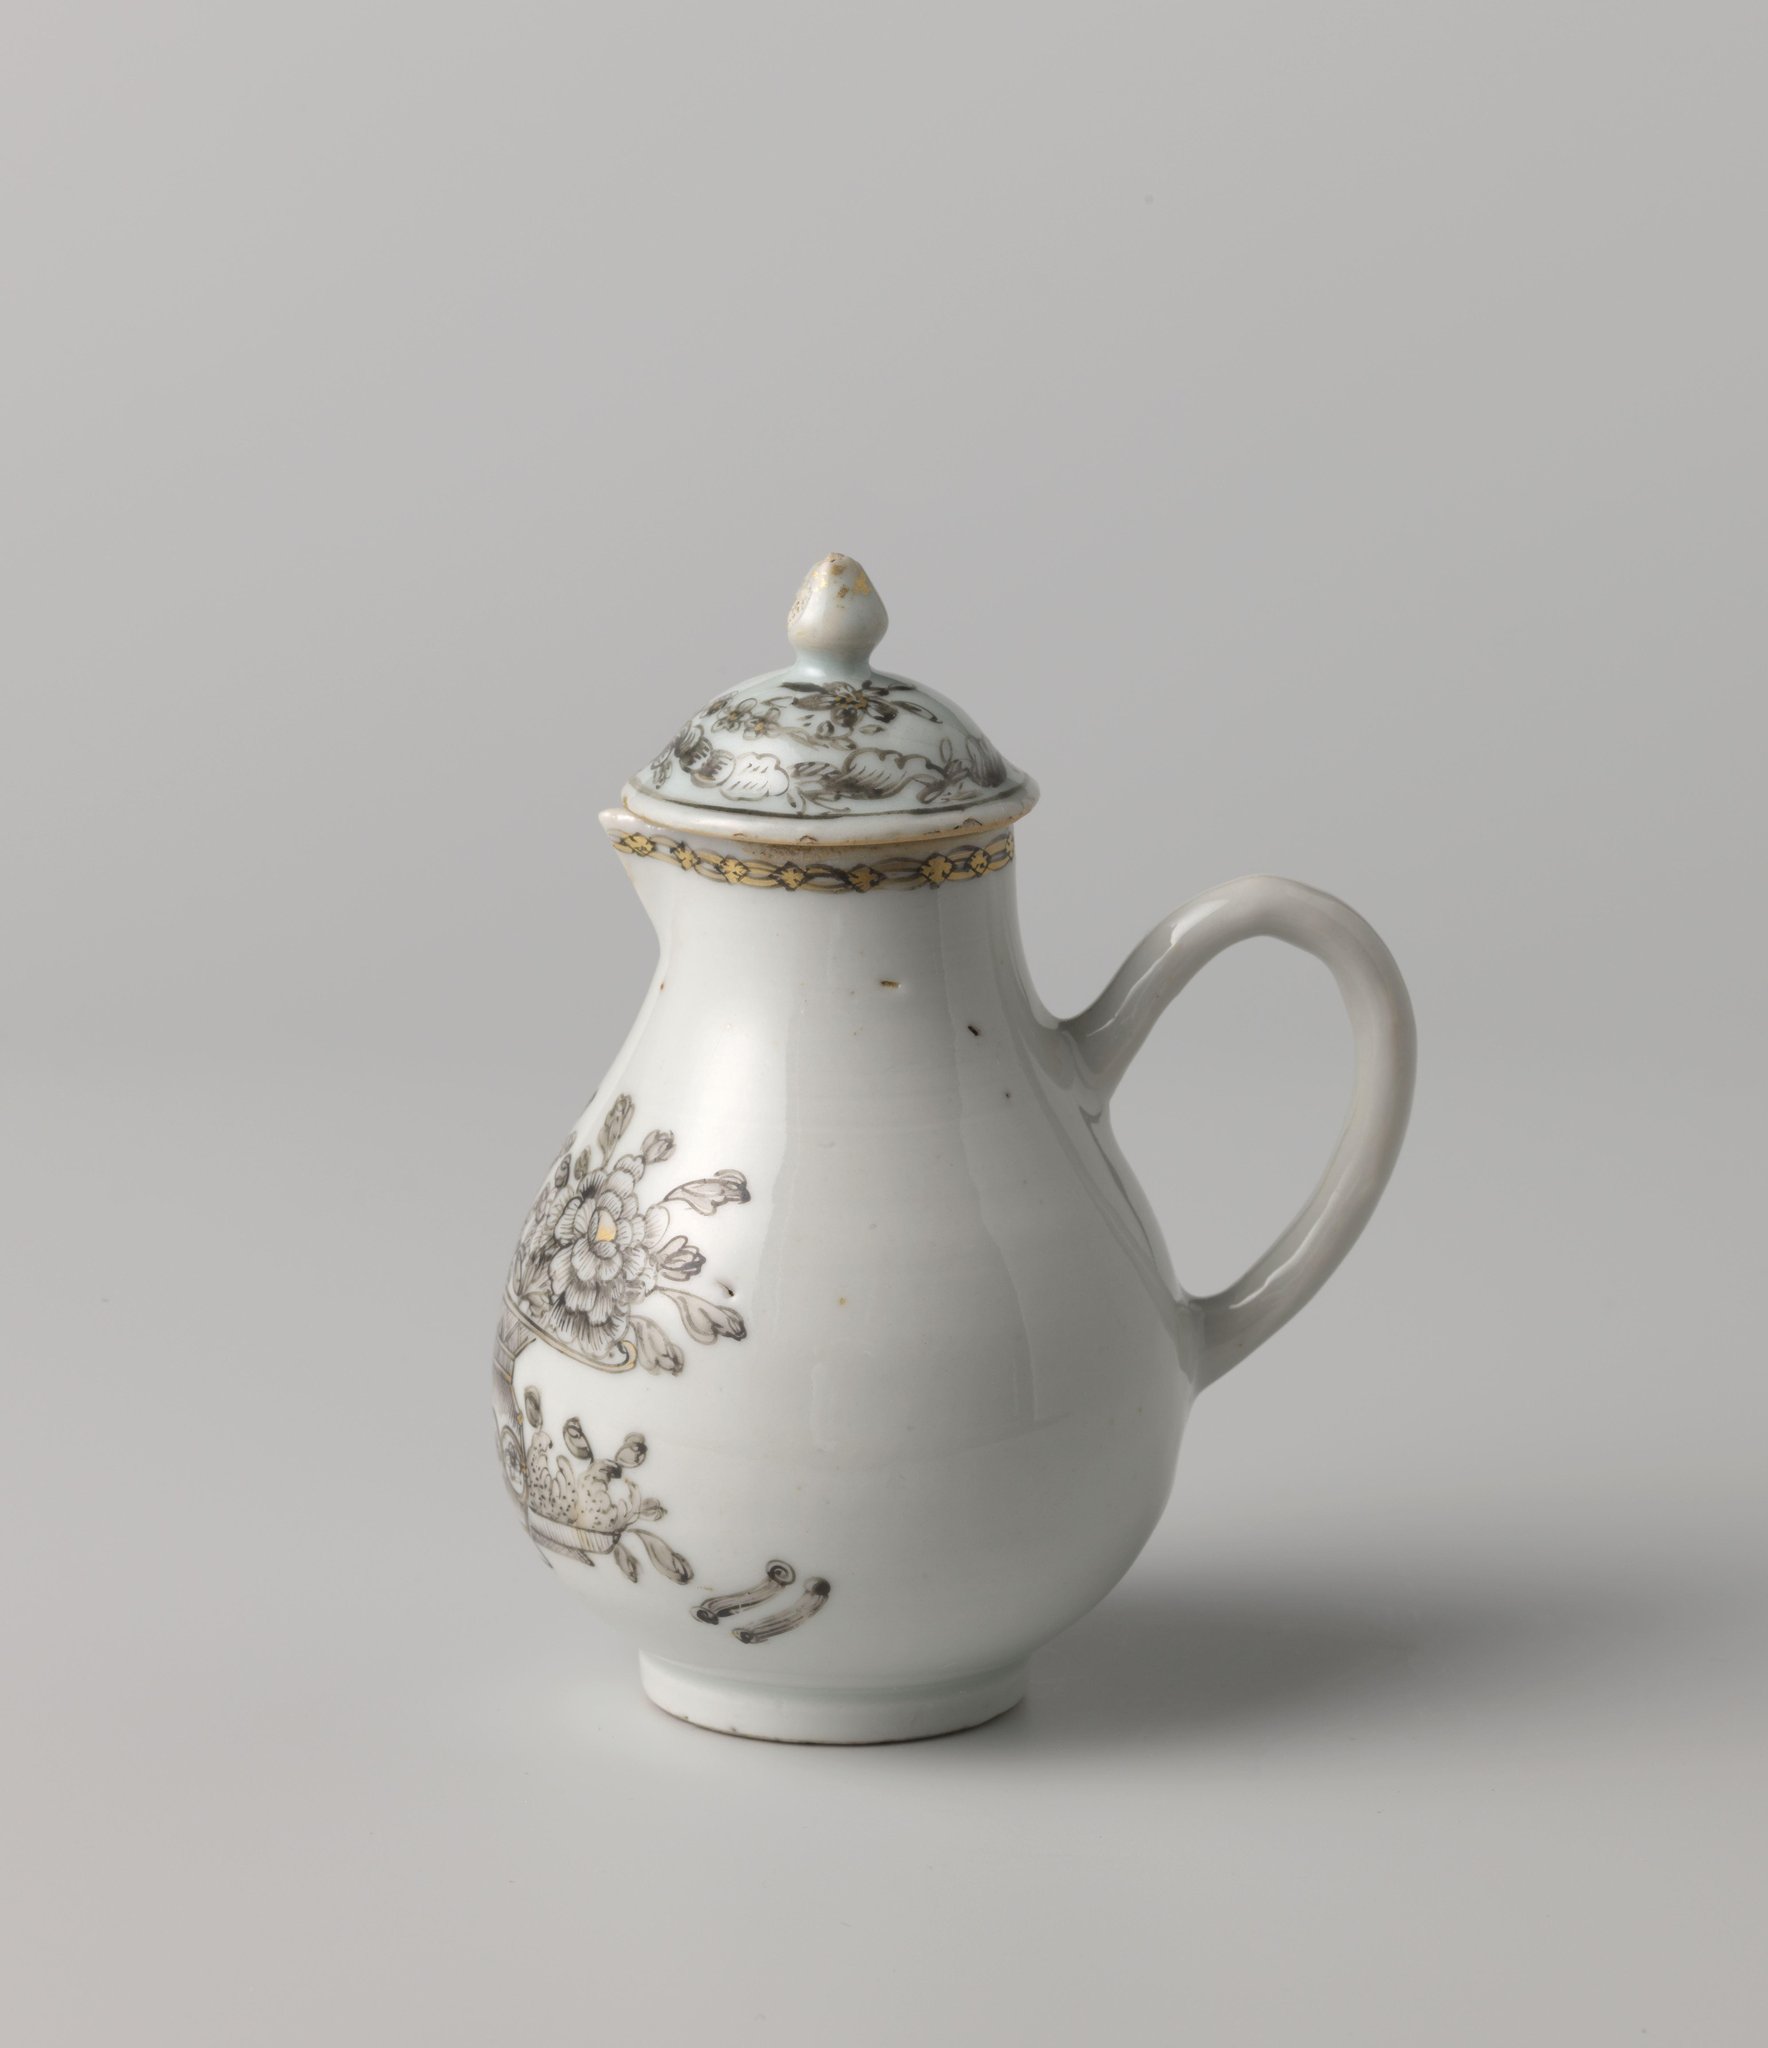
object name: milk jug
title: Pear-shaped milk jug with a flower and fruit basket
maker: Anonymous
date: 1725-1749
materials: glaze, gold, paint, porcelain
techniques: firing, gilding, turning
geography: china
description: Melkkan met deksel van porselein. Beschilderd in encre de Chine en goud met een mand en platte schaal met bloemen. Op het deksel bladeren en bloemen. Het deksel hoort niet bij de kan.